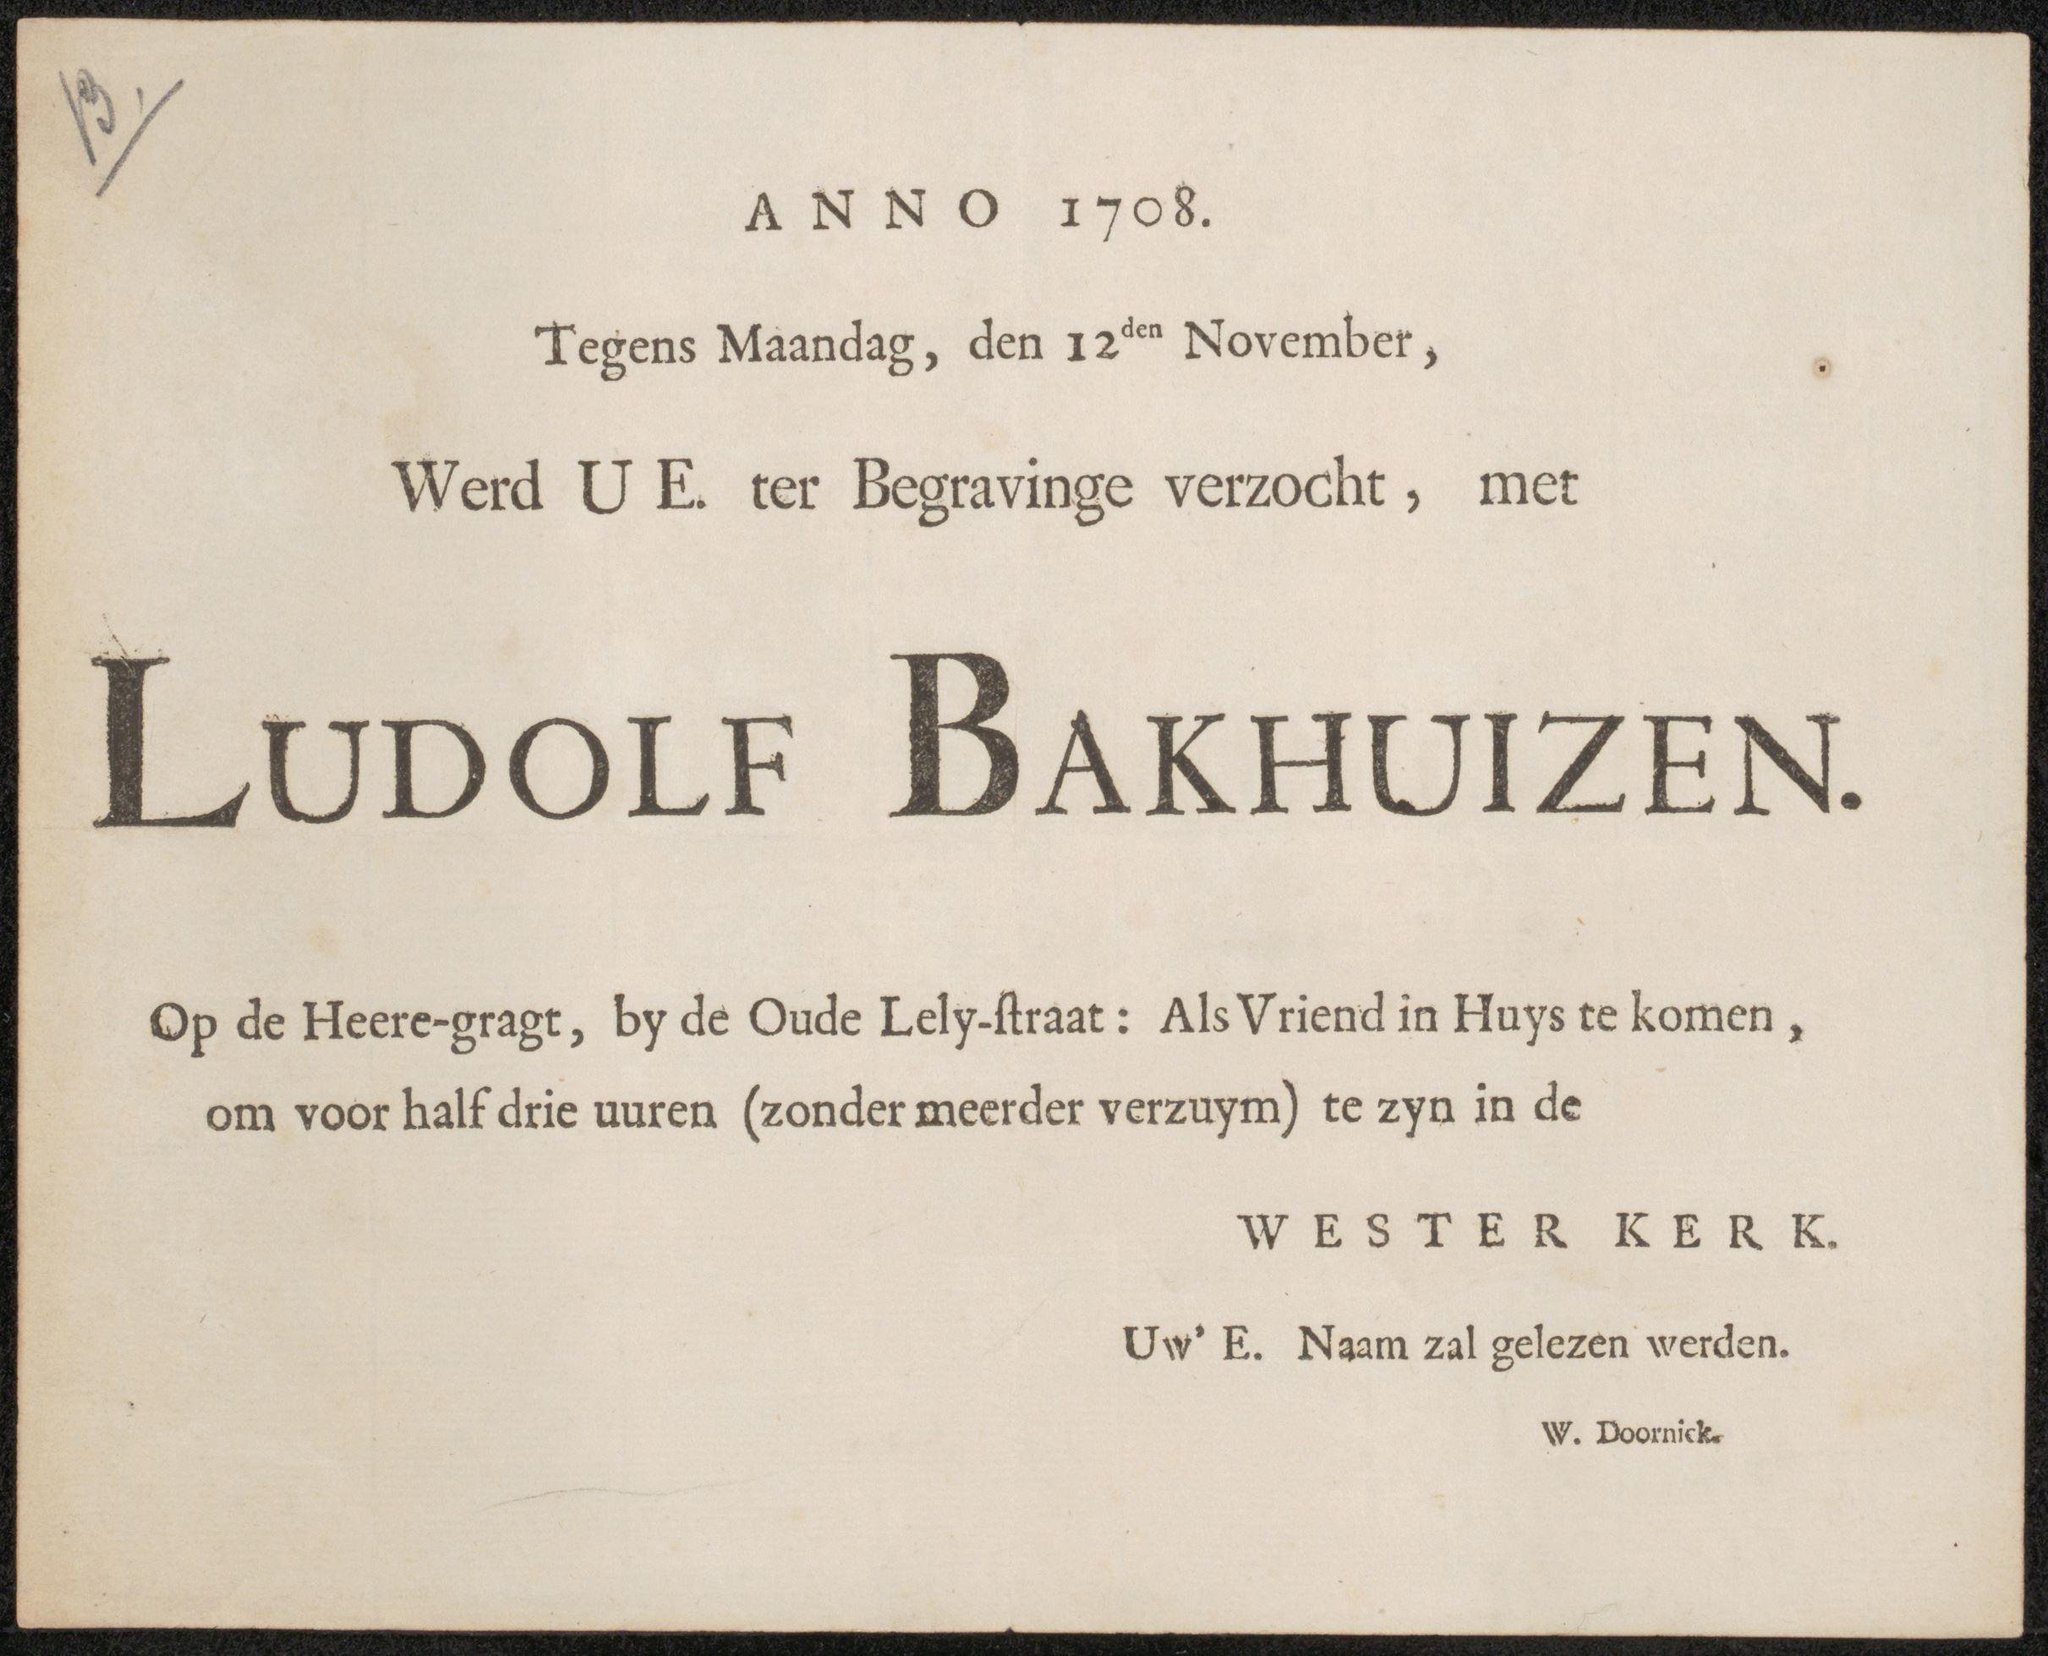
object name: invitation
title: Uitnodiging voor de begrafenis van Ludolf Bakhuysen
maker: w. doornick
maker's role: printer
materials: paper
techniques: printing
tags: amsterdam, print maker, draughtsman, ludolf bakhuysen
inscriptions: collector's mark: Lugt 2233